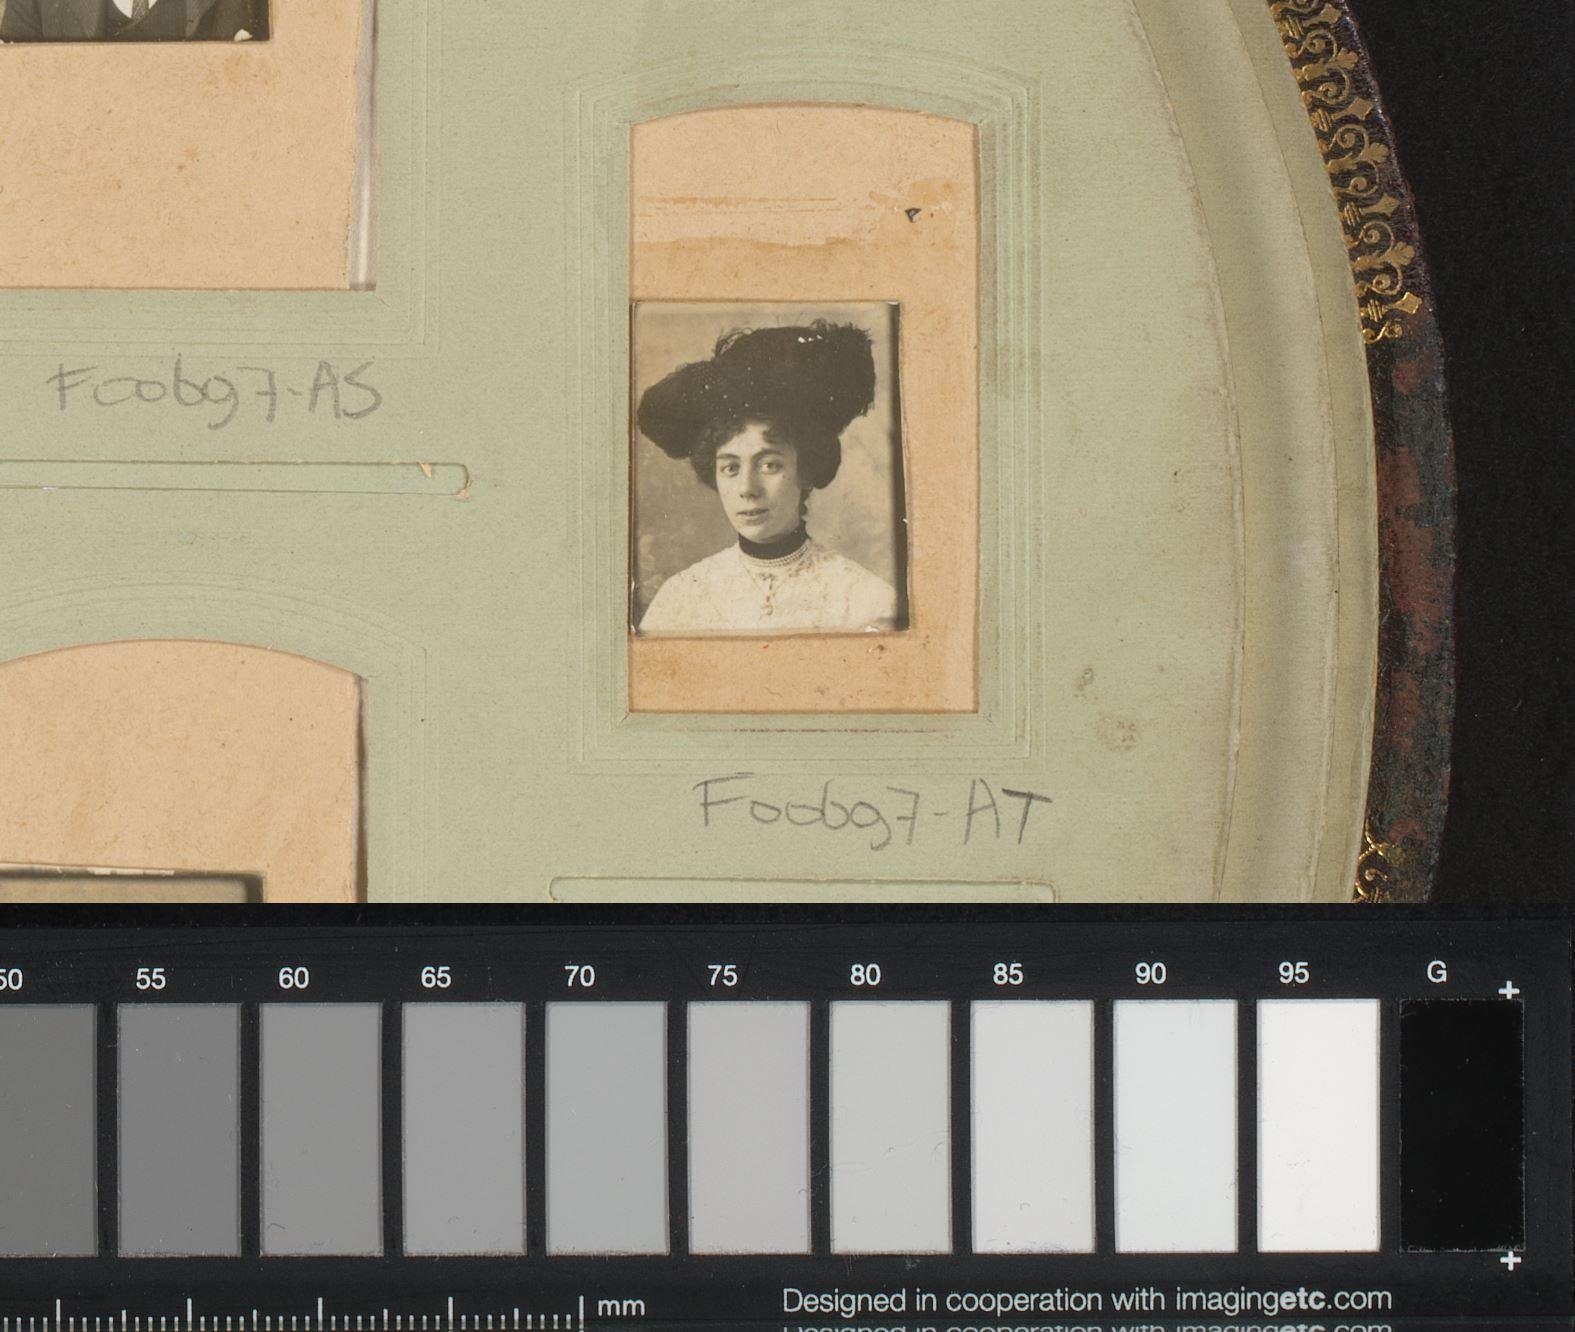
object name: snapshot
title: Portret van een vrouw met hoed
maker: Anonymous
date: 1890-1910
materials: photographic support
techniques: gelatin silver print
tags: adult woman, historical persons, head-gear: hat